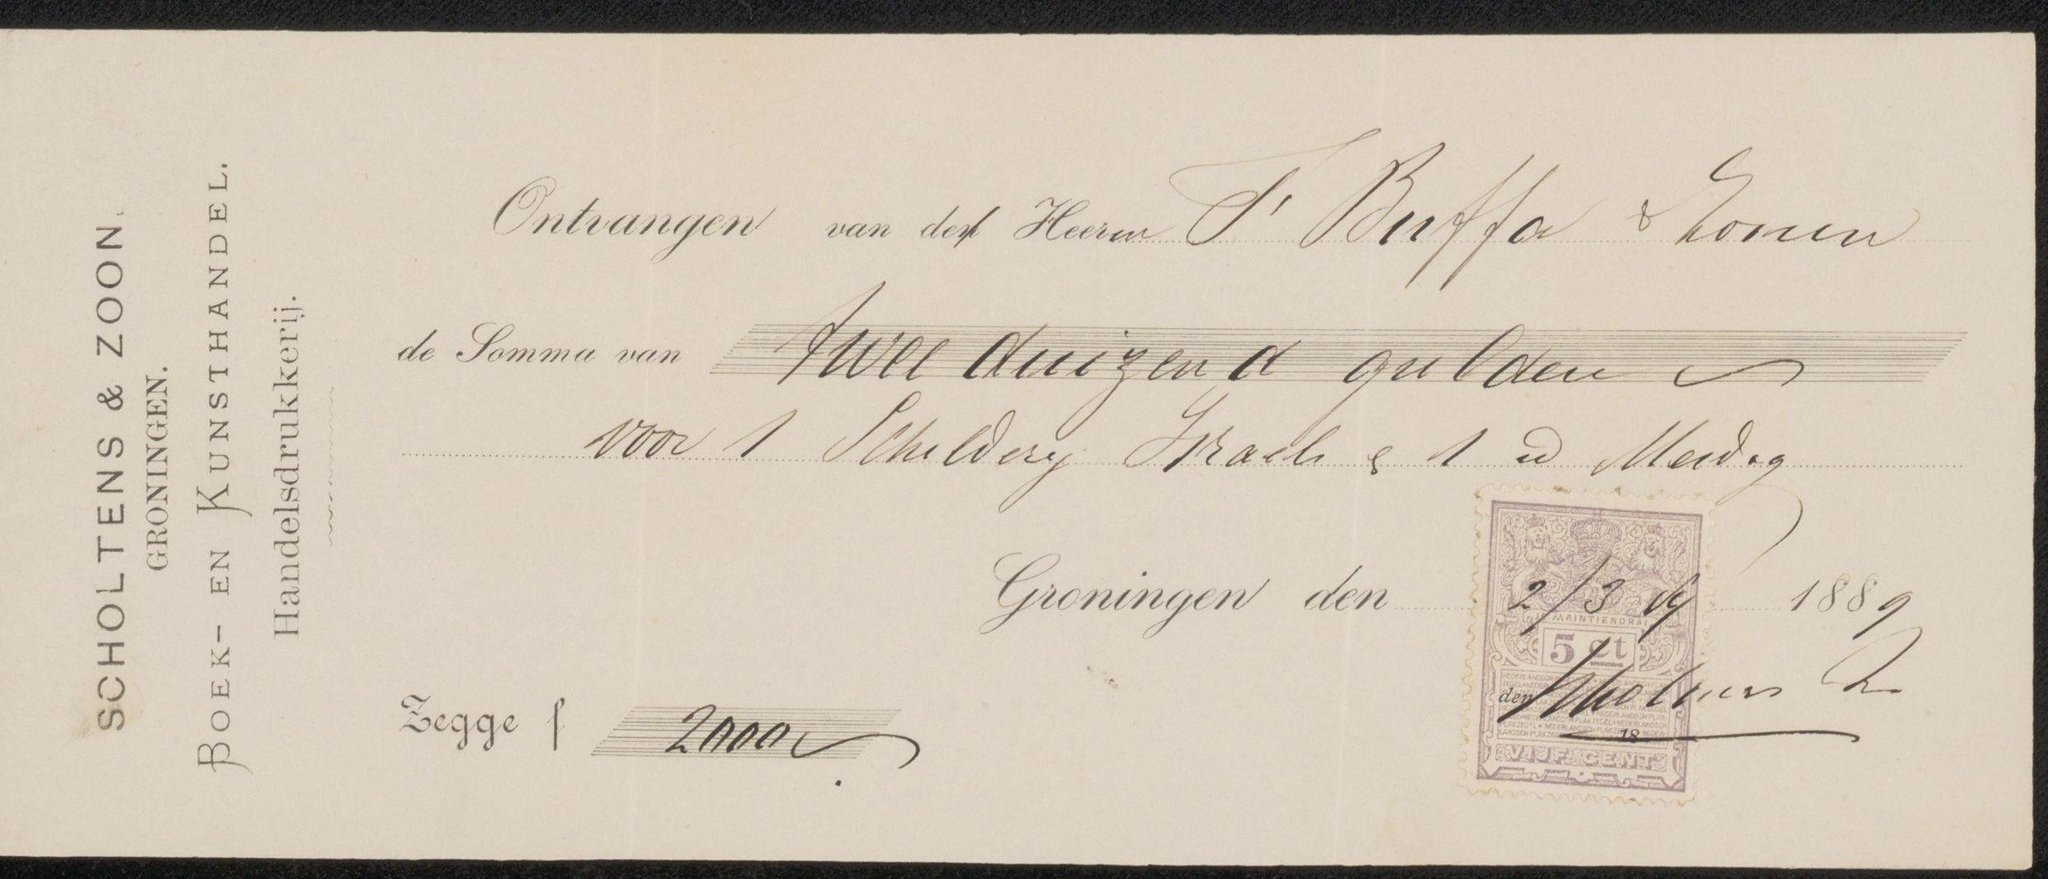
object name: ontvangstbewijs, kwitantie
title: Kwitantie voor Scholtens & Zoon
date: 1889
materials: ink, paper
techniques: pen, printing, writing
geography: groningen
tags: jozef israëls, the hague, painter, print maker, draughtsman, hendrik willem mesdag, drawing, money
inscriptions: collector's mark: Lugt 2233